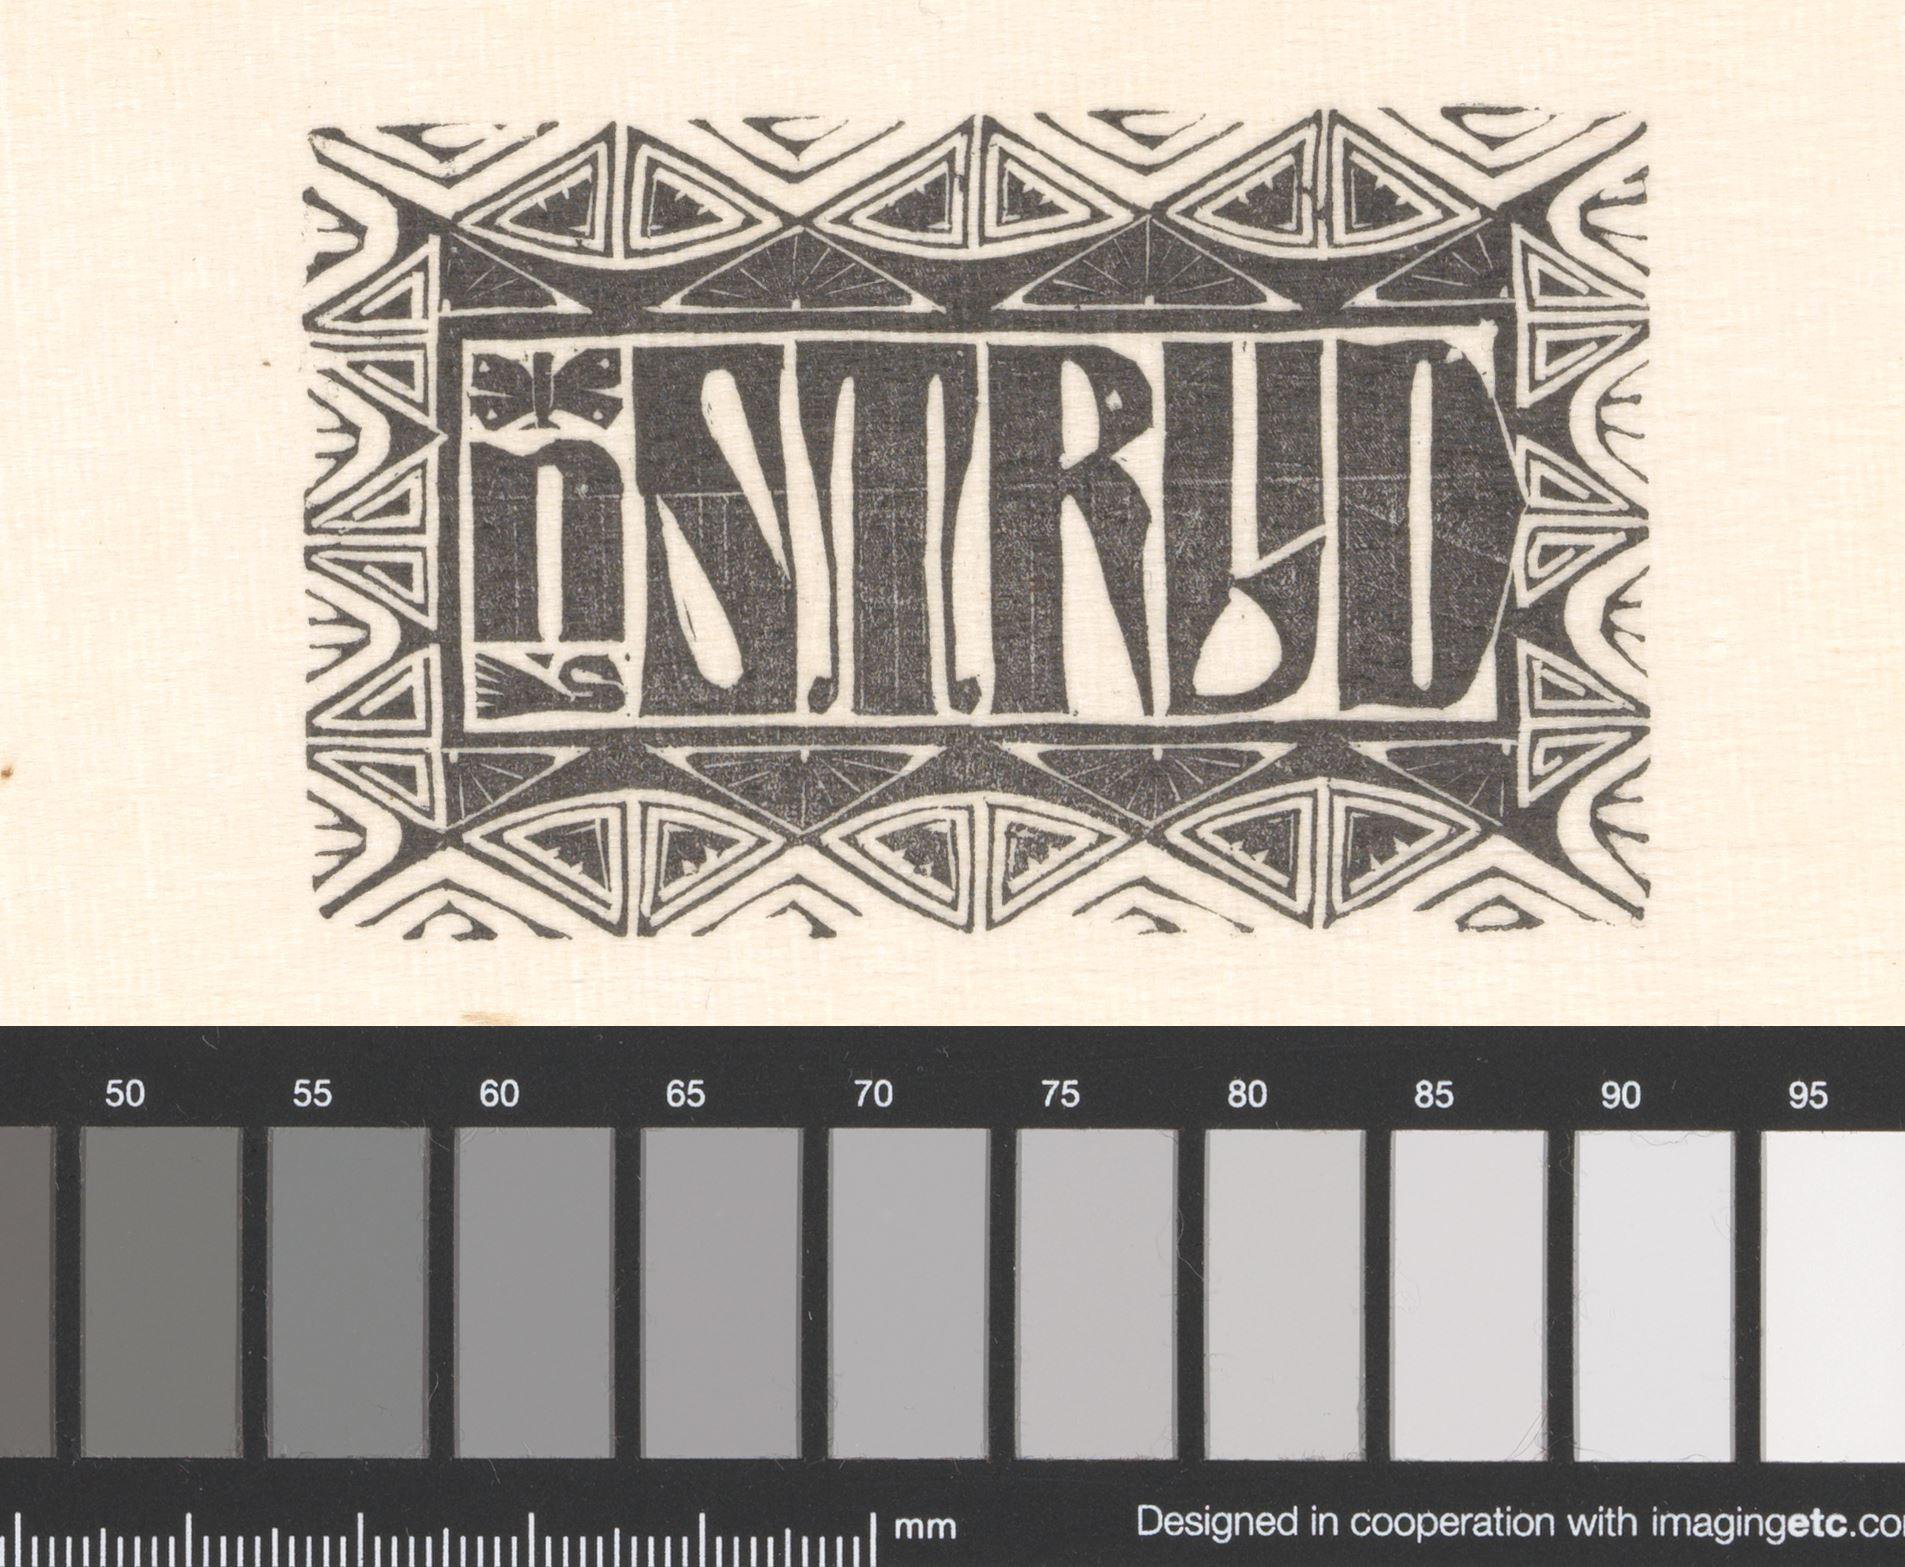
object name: illustration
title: Kopstuk met de letters 'n strijd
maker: mathieu lauweriks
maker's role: designer, draughtsman, print maker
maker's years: 1864-1932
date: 1895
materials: paper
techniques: woodcut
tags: water-birds: swan, insects: butterfly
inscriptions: collector's mark: Lugt 2228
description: Prent mogelijk gebruikt voor: Licht en waarheid. Orgaan van de vereeniging 'Wie Denkt Overwint'. Amsterdam: Wie Denkt Overwint, 19 januari 1895.